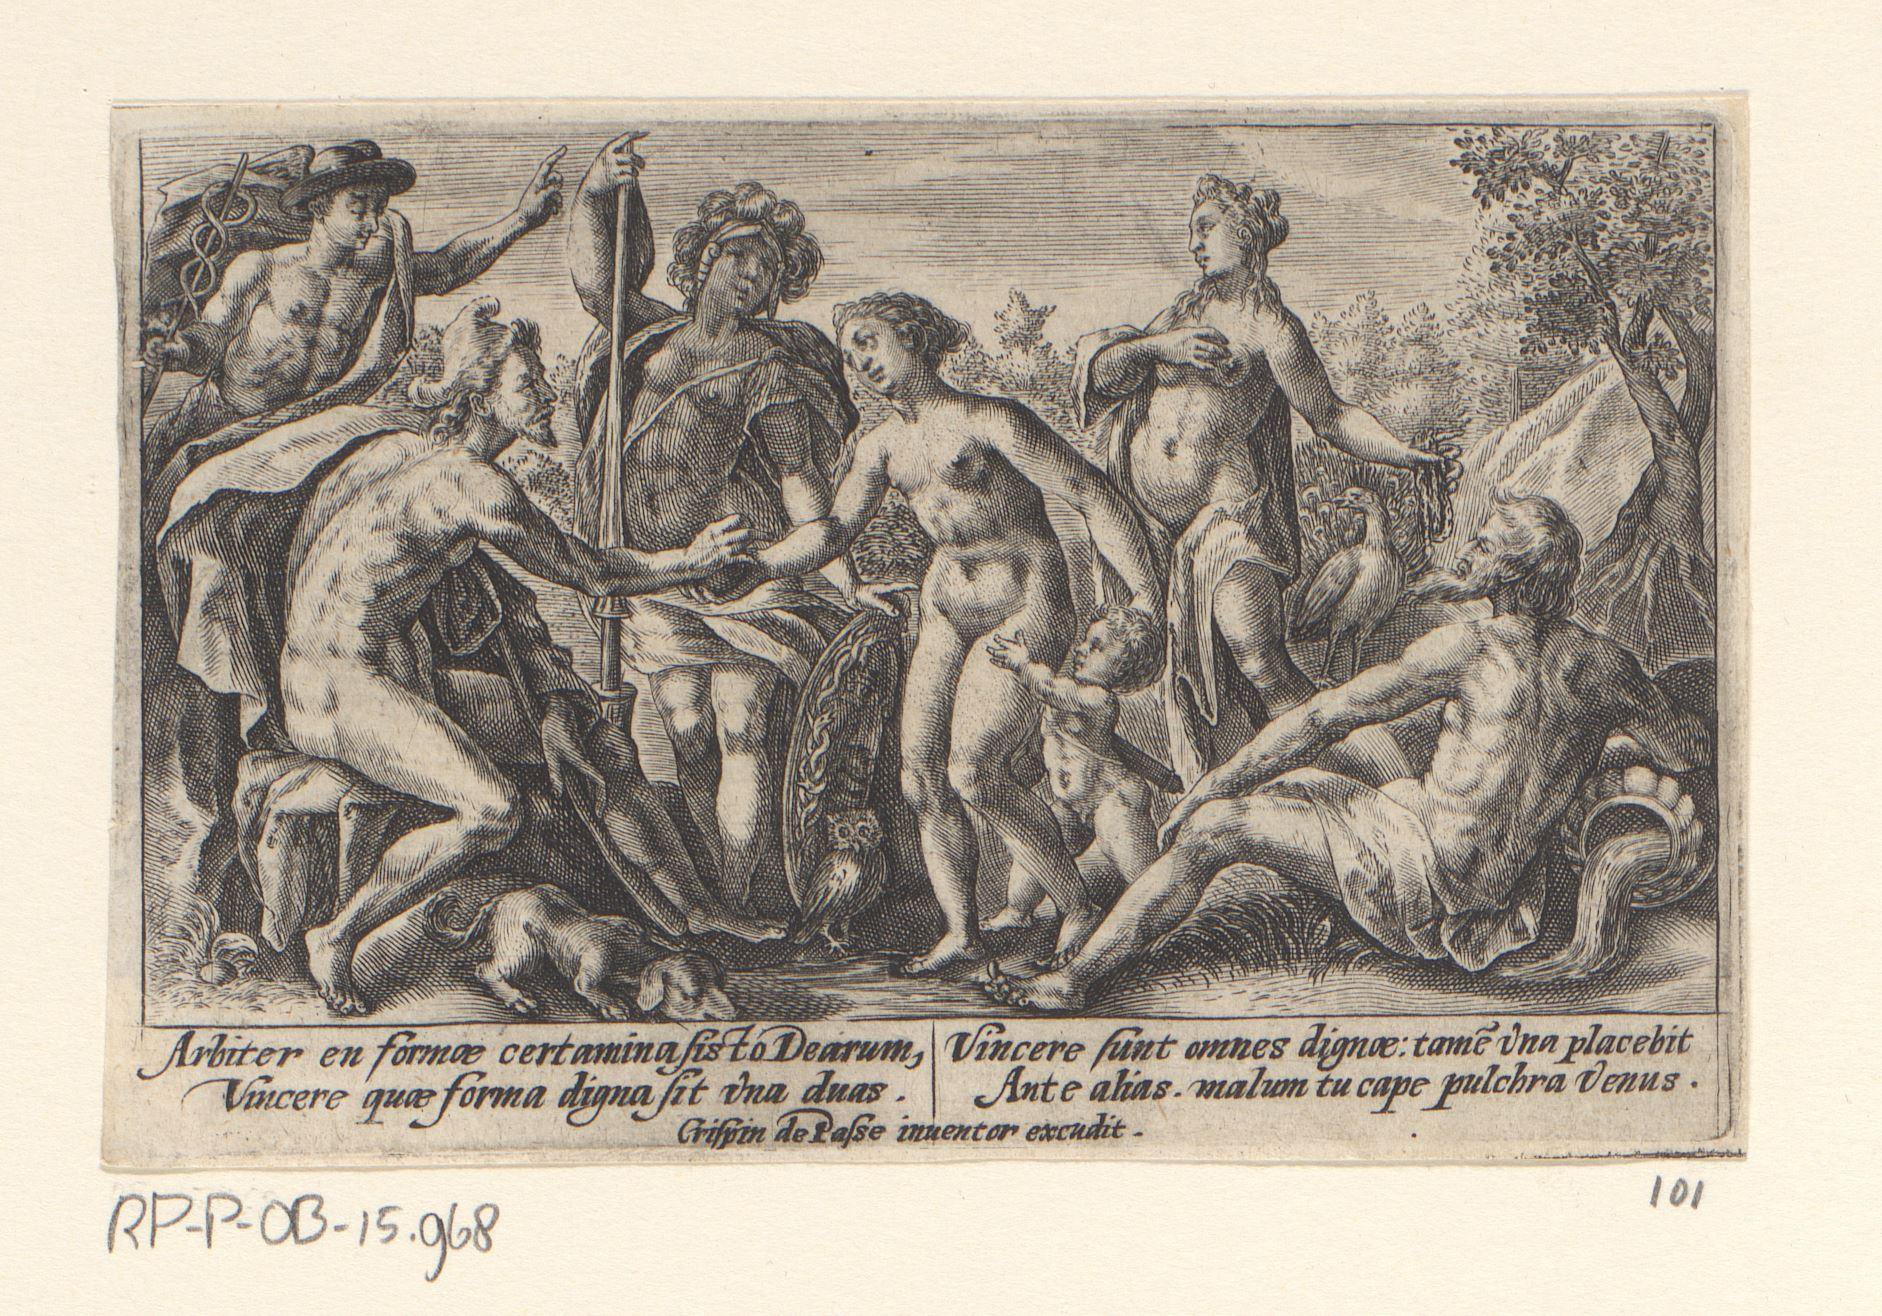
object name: print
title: Oordeel van Paris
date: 1602-1607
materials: paper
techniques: engraving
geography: cologne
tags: the judgement of paris (mercury present)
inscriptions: collector's mark: Lugt 2228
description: Paris moet de drie mooiste godinnen van de Olympus beoordelen op hun schoonheid: Juno (met de pauw), Venus (vergezeld door Amor) en Minerva (vergezeld door een uil). Paris geeft de gouden appel van Eris aan Venus. Mercurius kijkt toe. In de marge een vierregelig onderschrift, in twee kolommen, in het Latijn.